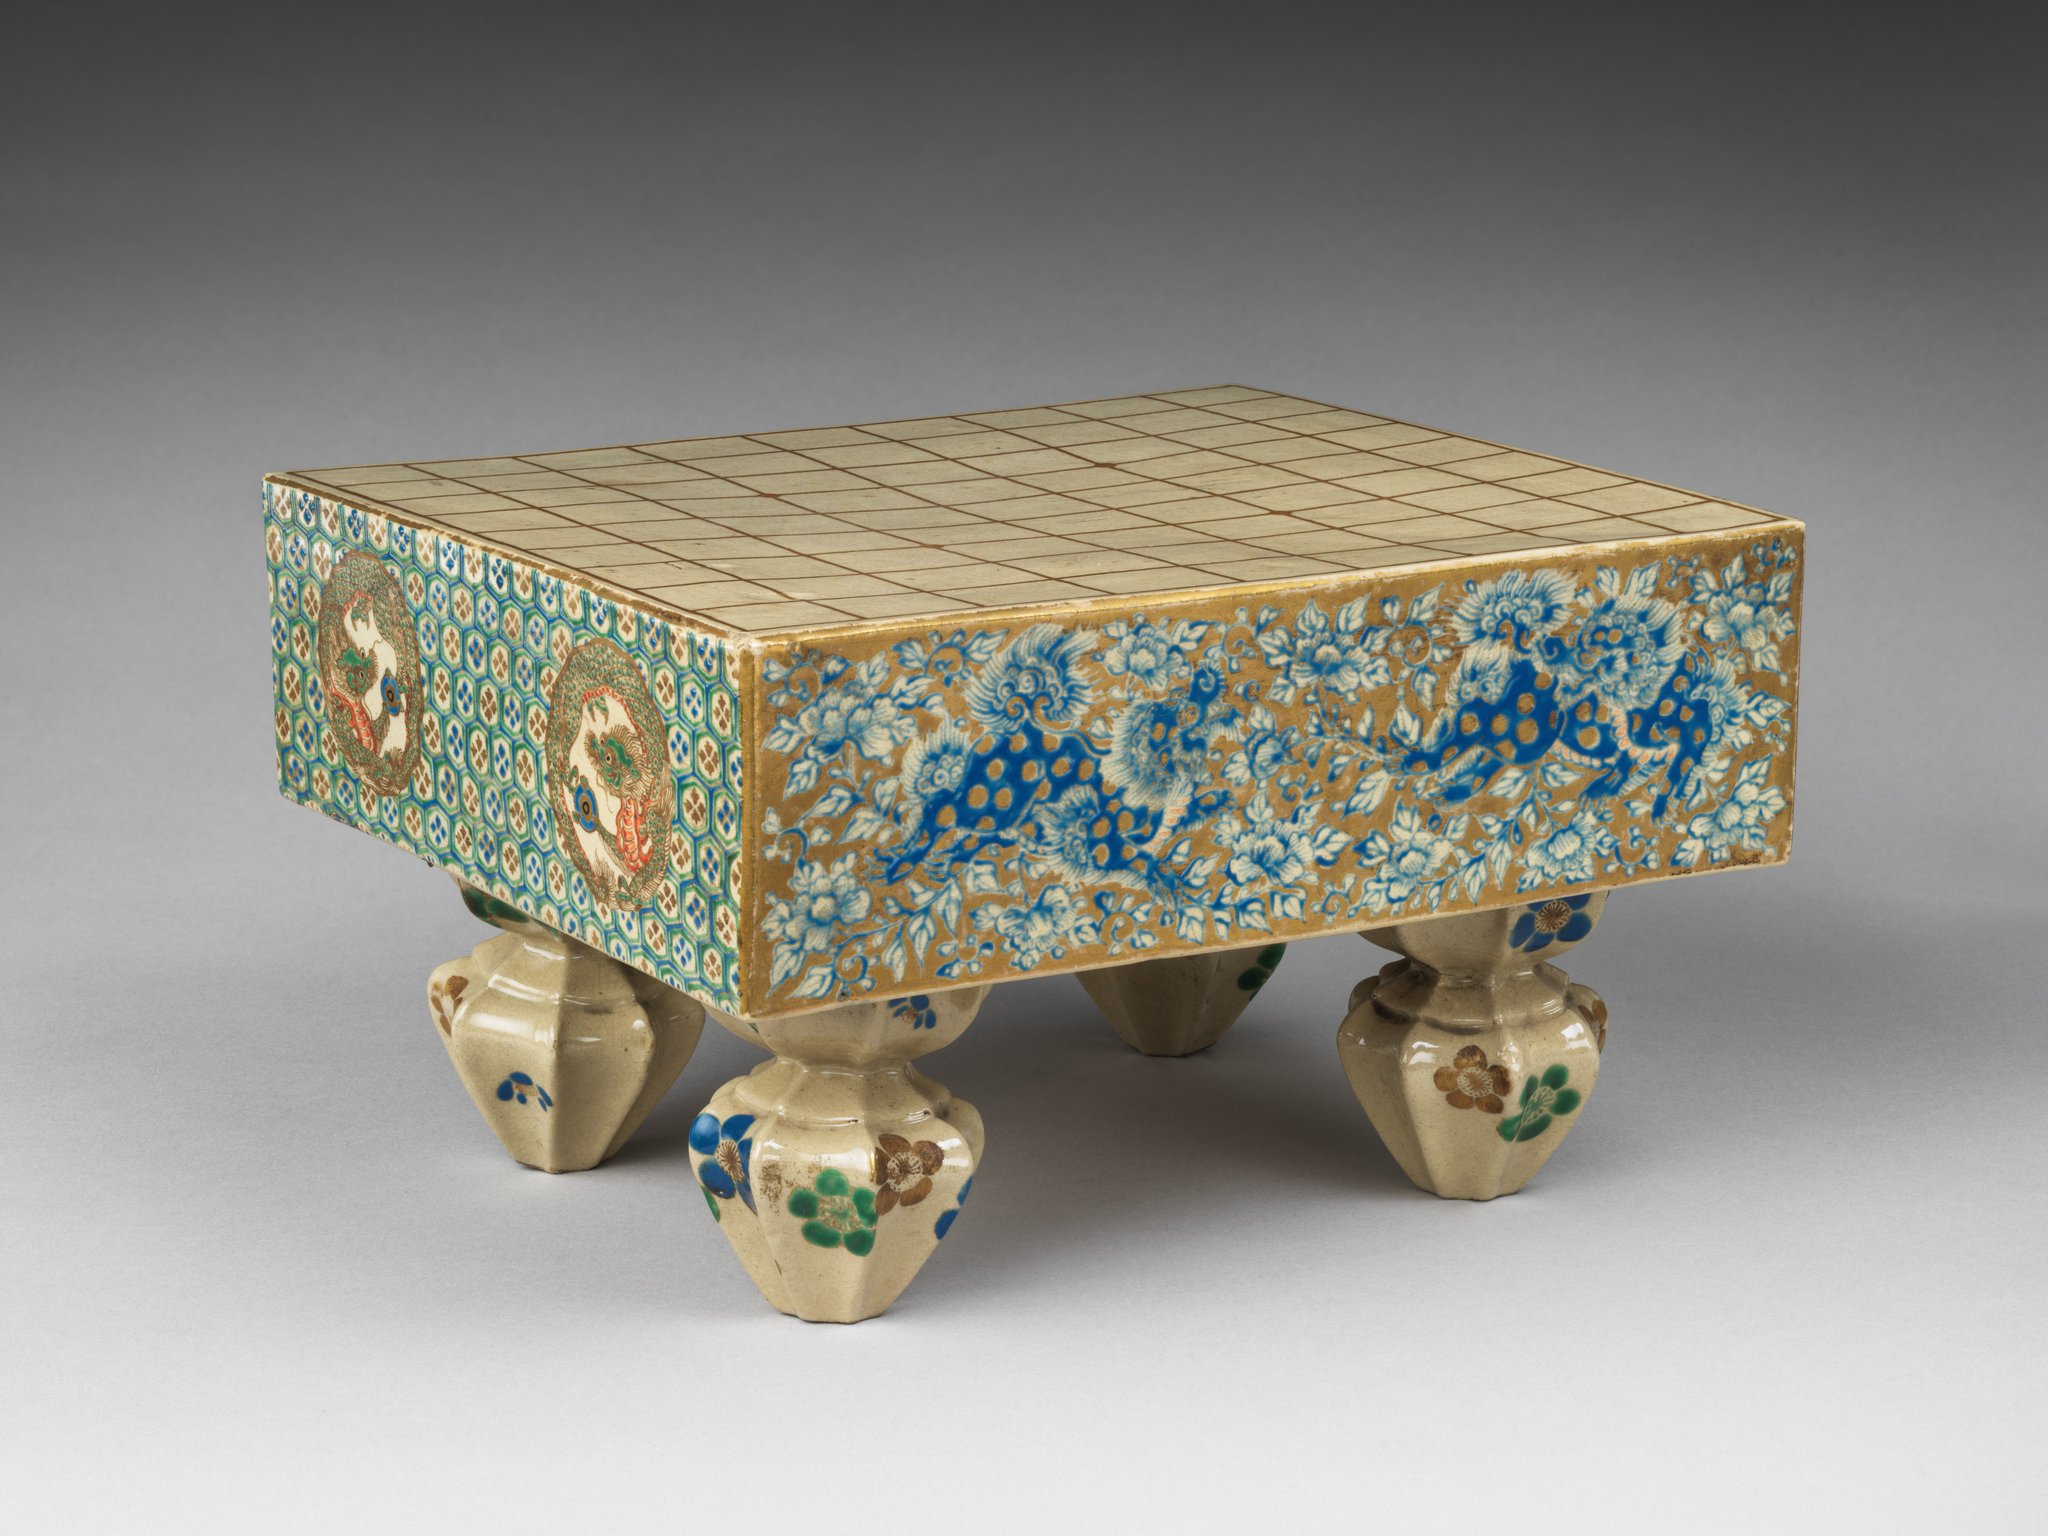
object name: chessboard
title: Chess board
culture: japanese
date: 1615-1868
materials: earthenware, glaze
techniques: polychrome